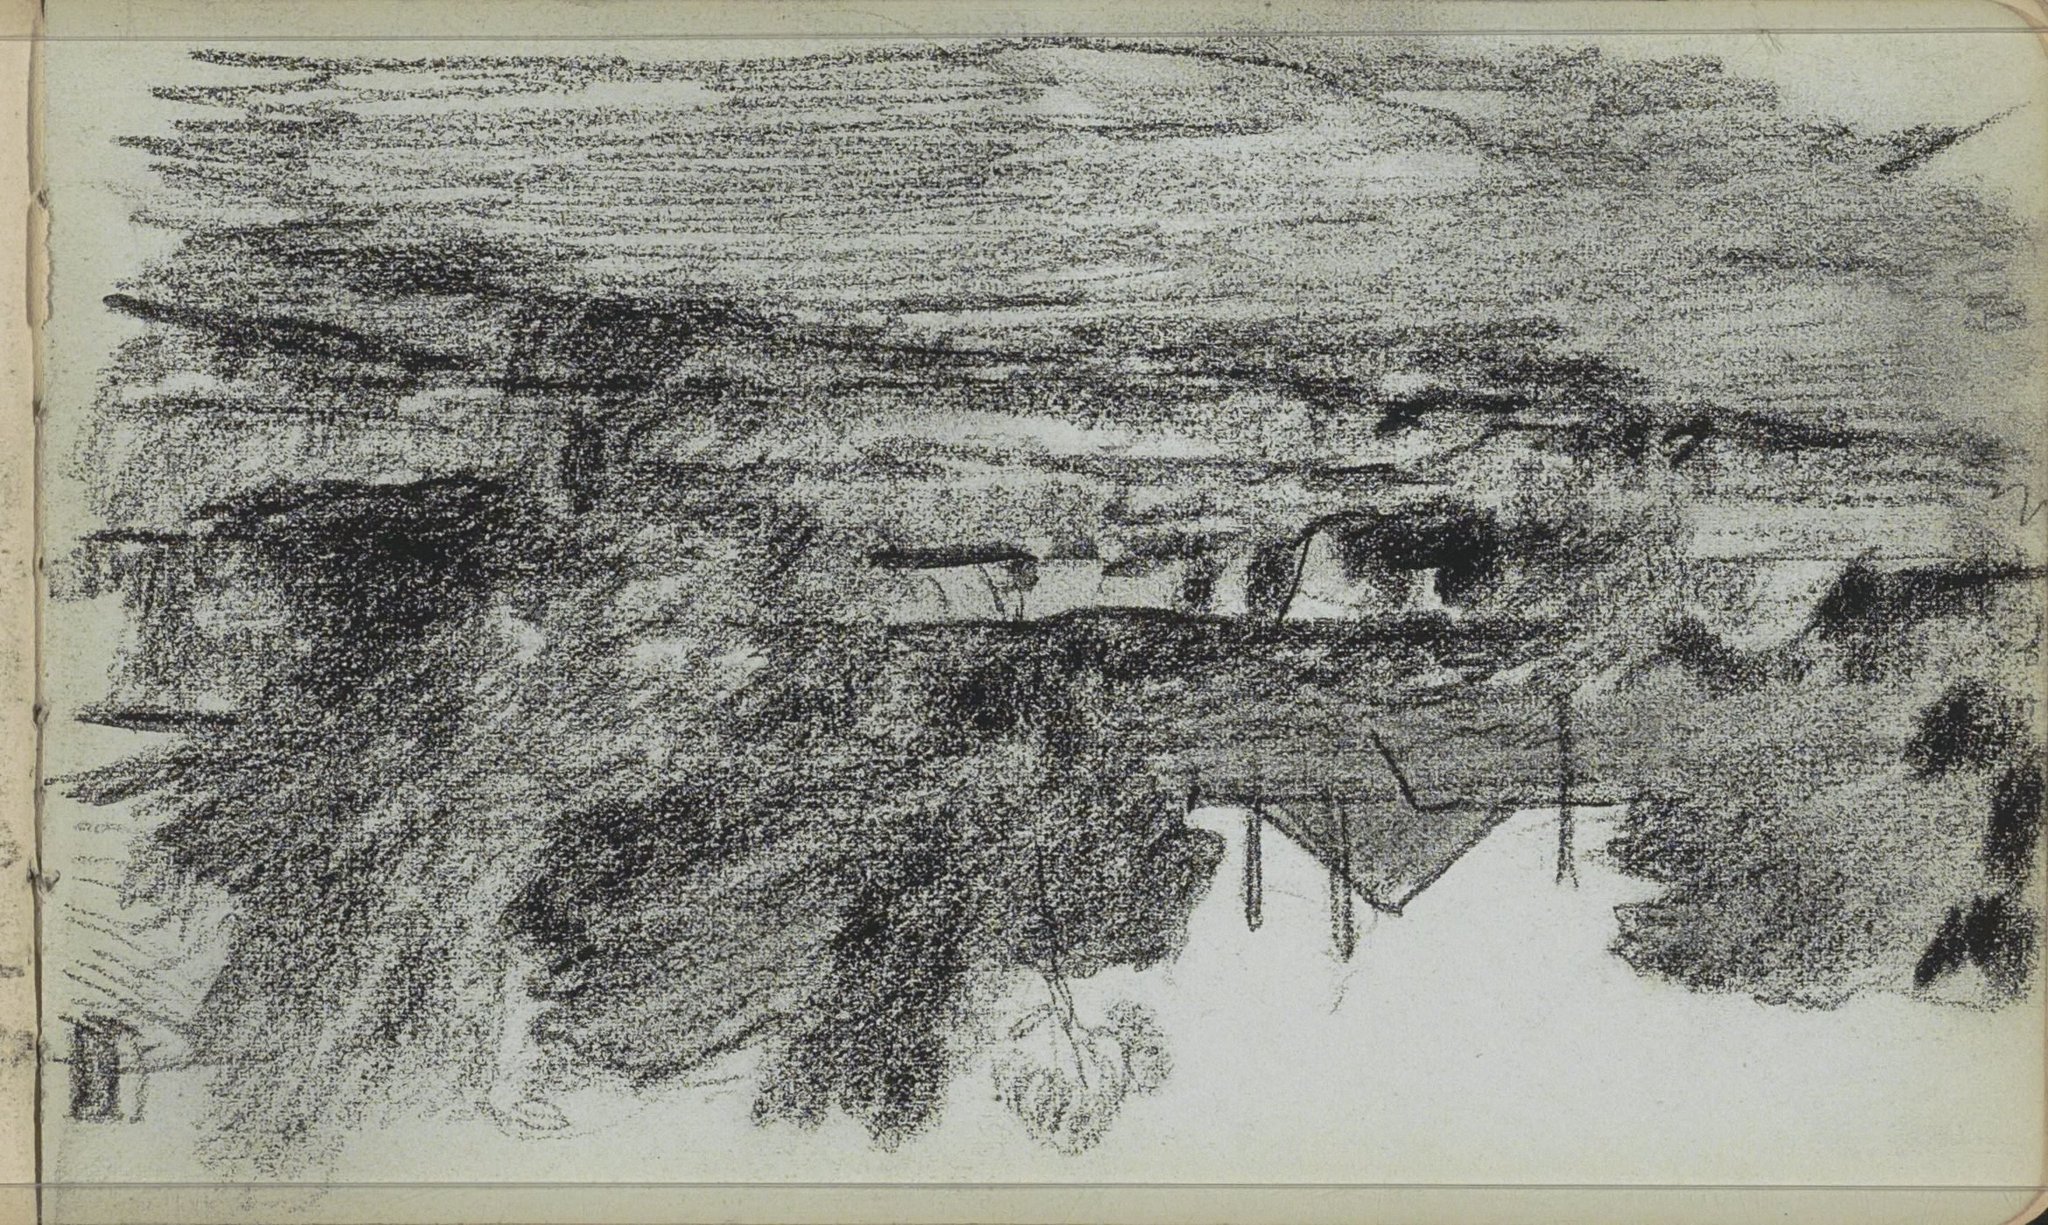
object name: sketchbook leaf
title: Rivierlandschap met gebouwen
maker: johan antonie de jonge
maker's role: draughtsman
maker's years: 1864-1927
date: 1881-1927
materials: chalk, paper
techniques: stumping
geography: south holland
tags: river, civic architecture; edifices; dwellings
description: Rivierlandschap met gebouwen. Blad 15 recto uit een schetsboek met 34 bladen.